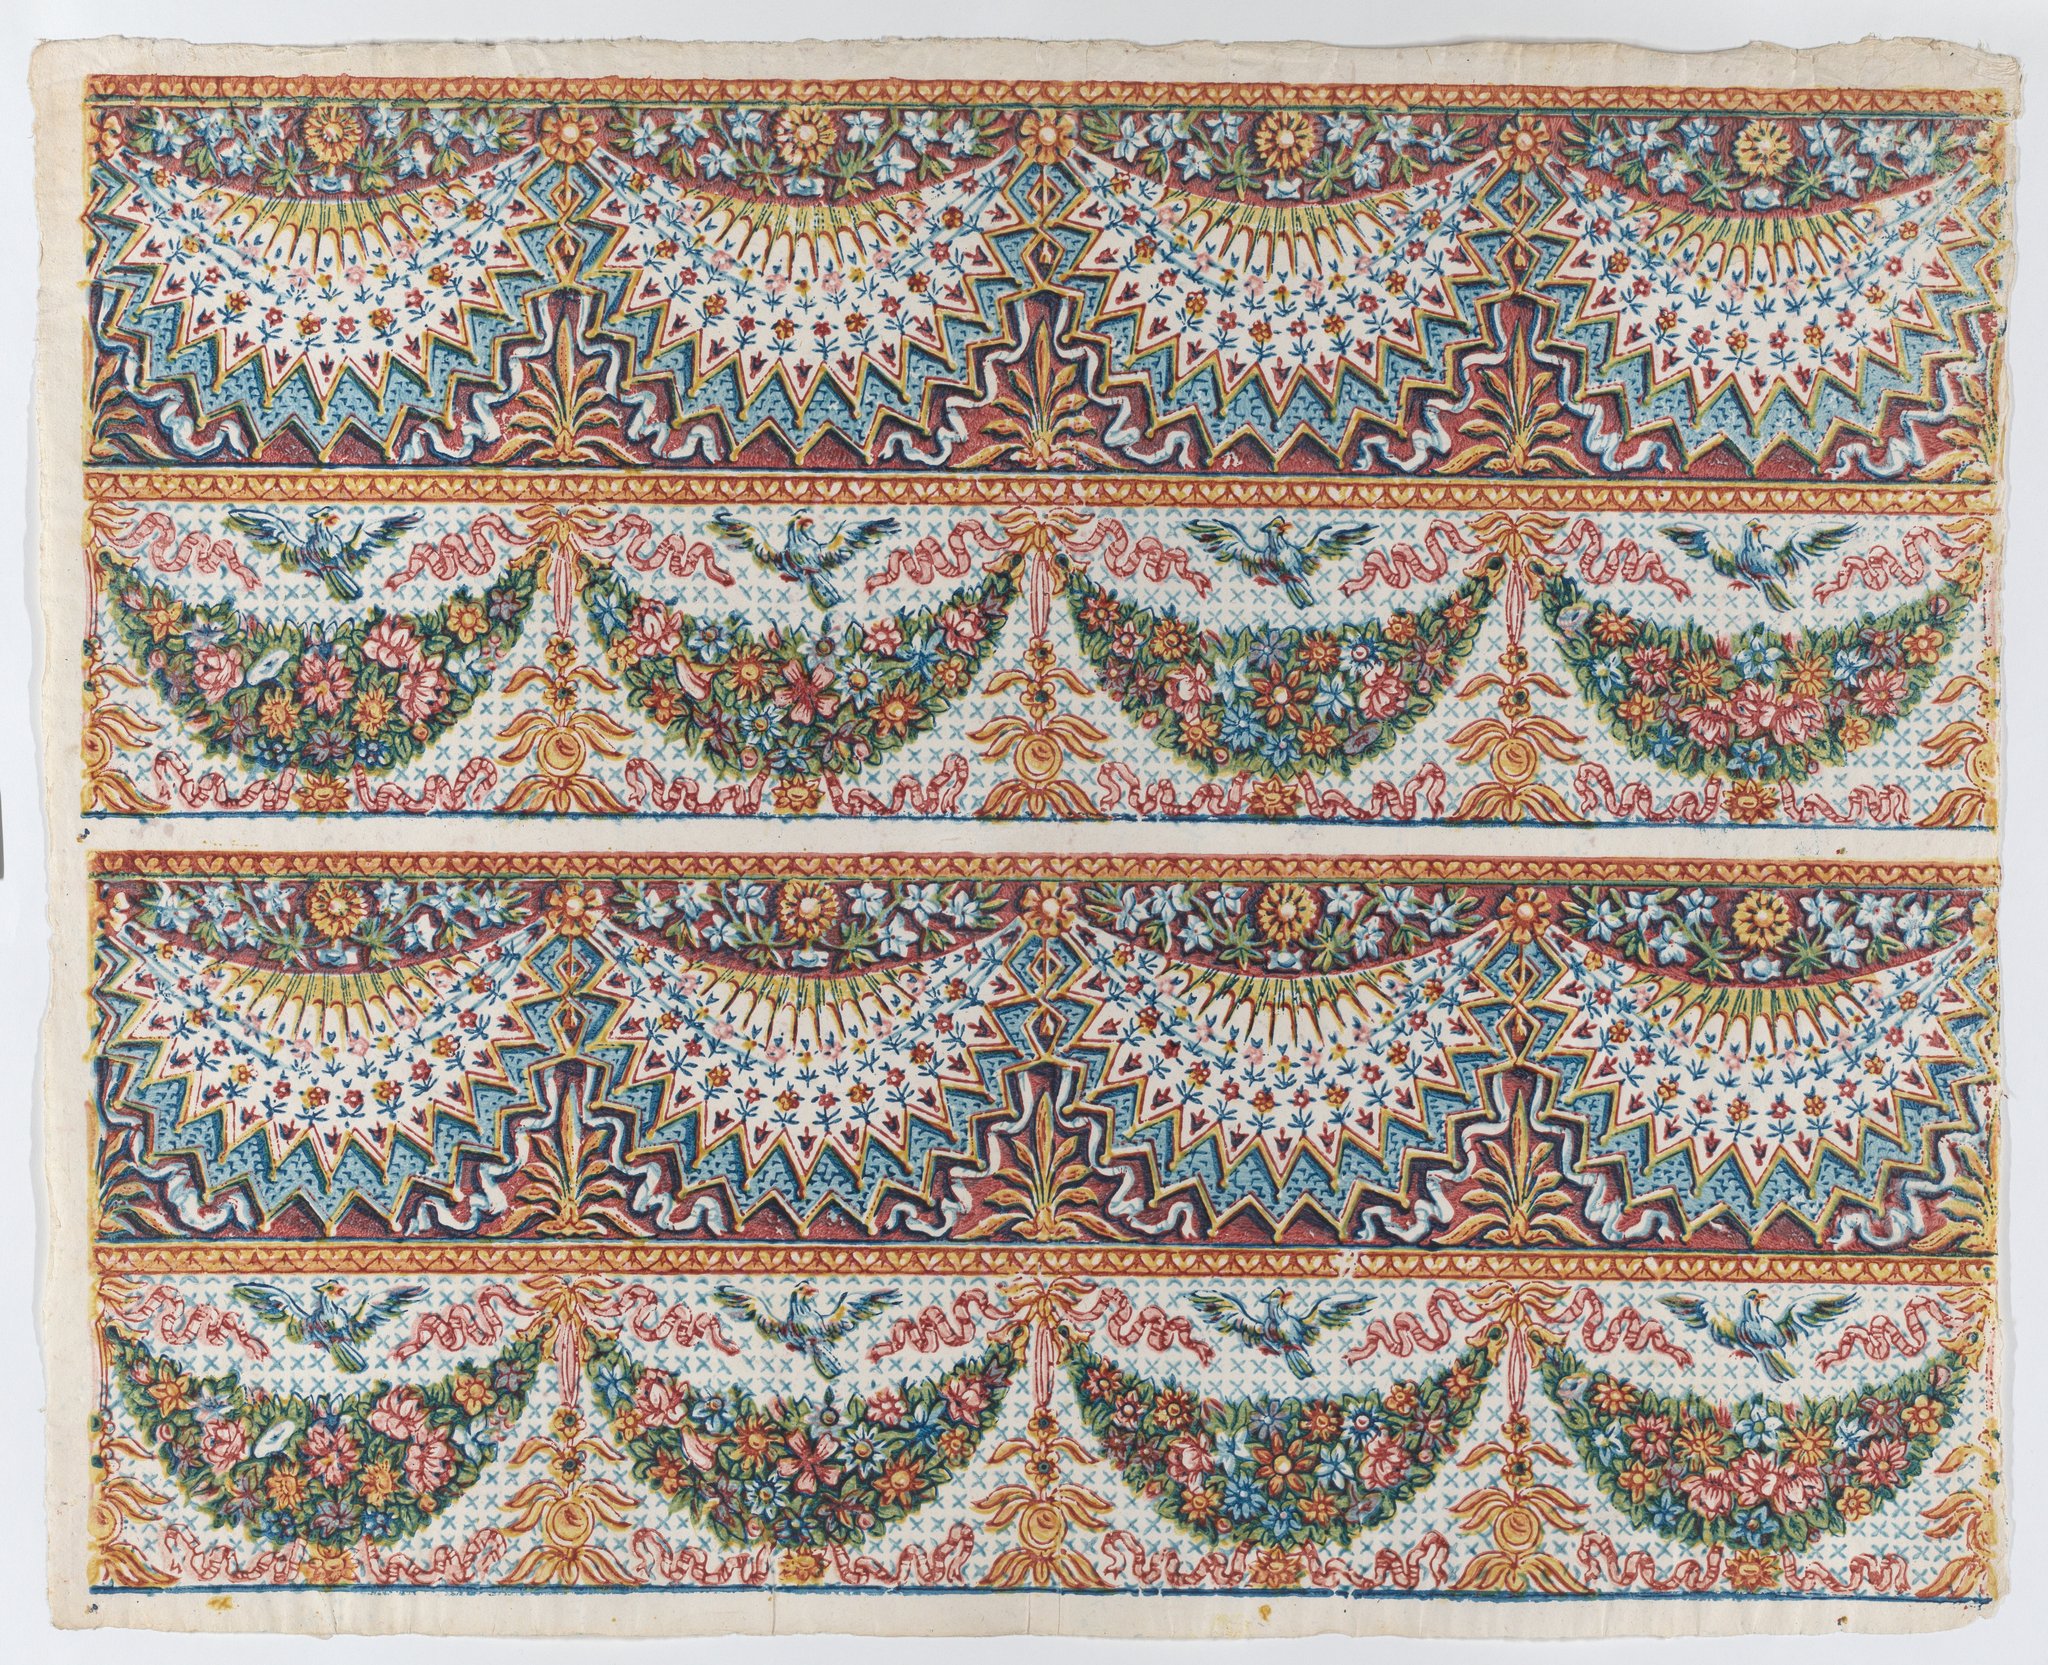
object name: print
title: Sheet with a two borders with four hanging draperies,multicolor festoons, and birds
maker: Anonymous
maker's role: artist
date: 1767-1866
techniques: relief print